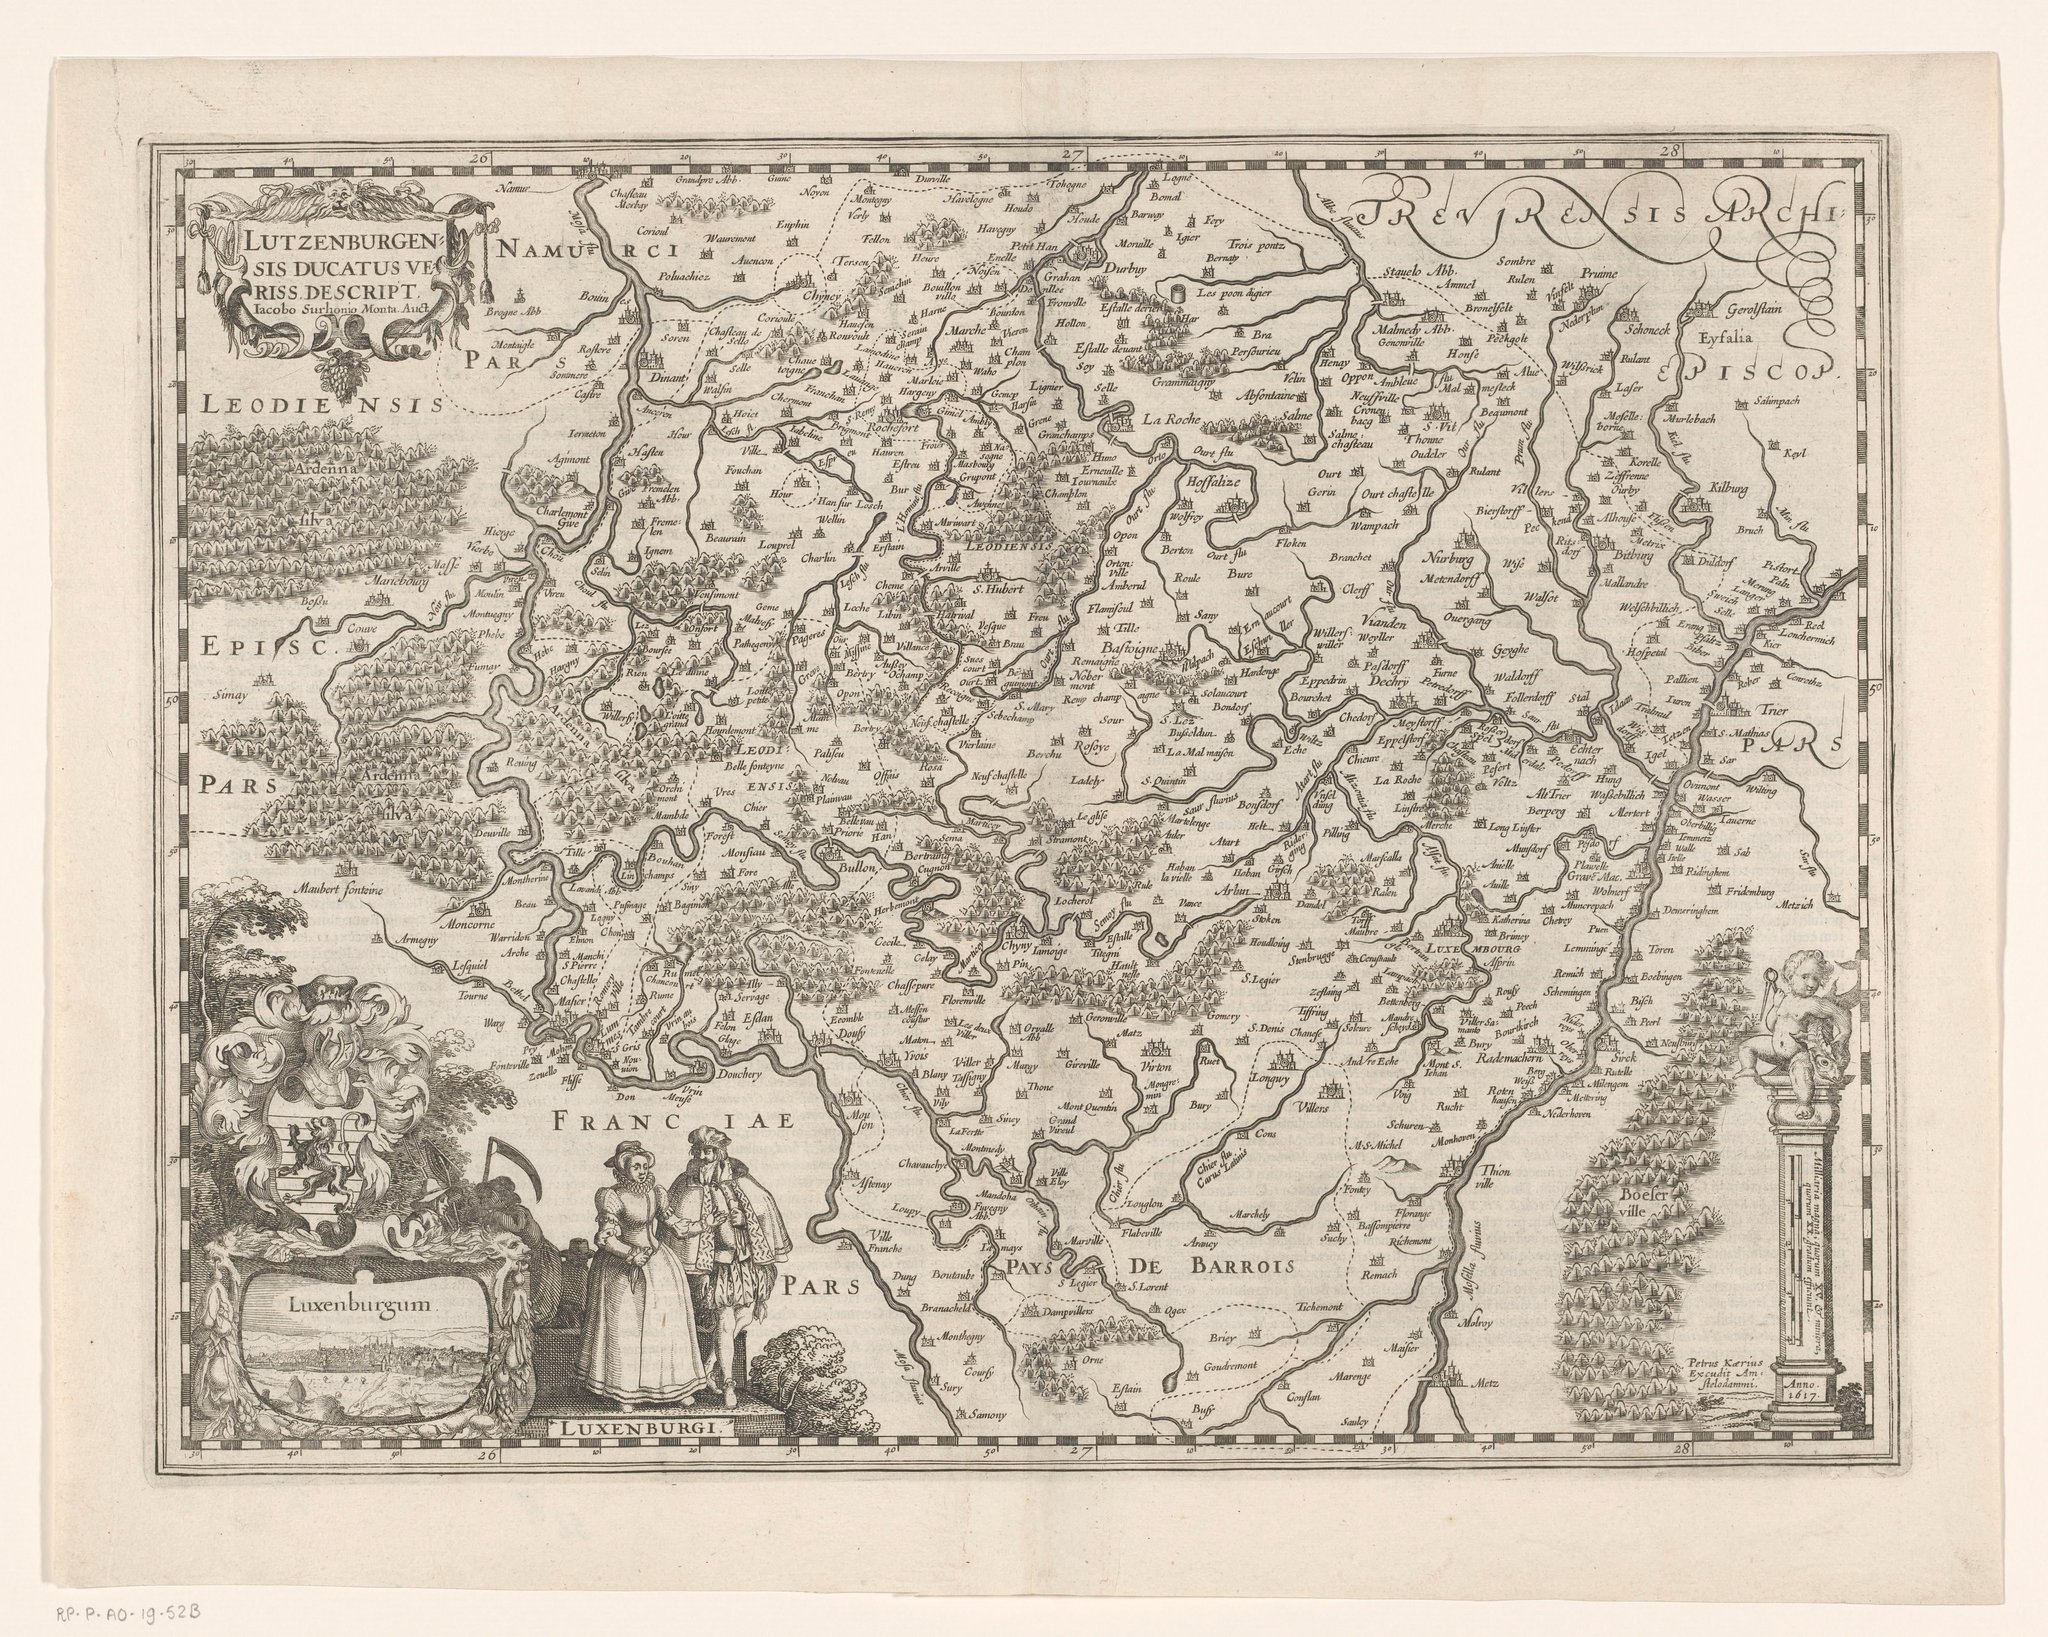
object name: print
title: Lutzenburgensis ducatus veriss. descript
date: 1617-1622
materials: paper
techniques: engraving, etching, letterpress printing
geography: amsterdam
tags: maps of separate countries or regions, folk costume, regional costume, coat of arms (as symbol of the state, etc.) (+ province; provincial), prospect of city, town panorama, silhouette of city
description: Kaart van het hertogdom Luxemburg. Linksboven een cartouche met de titel. Linksonder een cartouche met een gezicht op de stad Luxemburg en het wapen van het hertogdom Luxemburg. Rechts daarvan twee kostuumfiguren, die inwoners van Luxemburg verbeelden. Rechtsonder een zuil met daarin twee schaalstokken. De kaart is voorzien van een gradenverdeling langs de randen. Op verso Latijnse tekst.